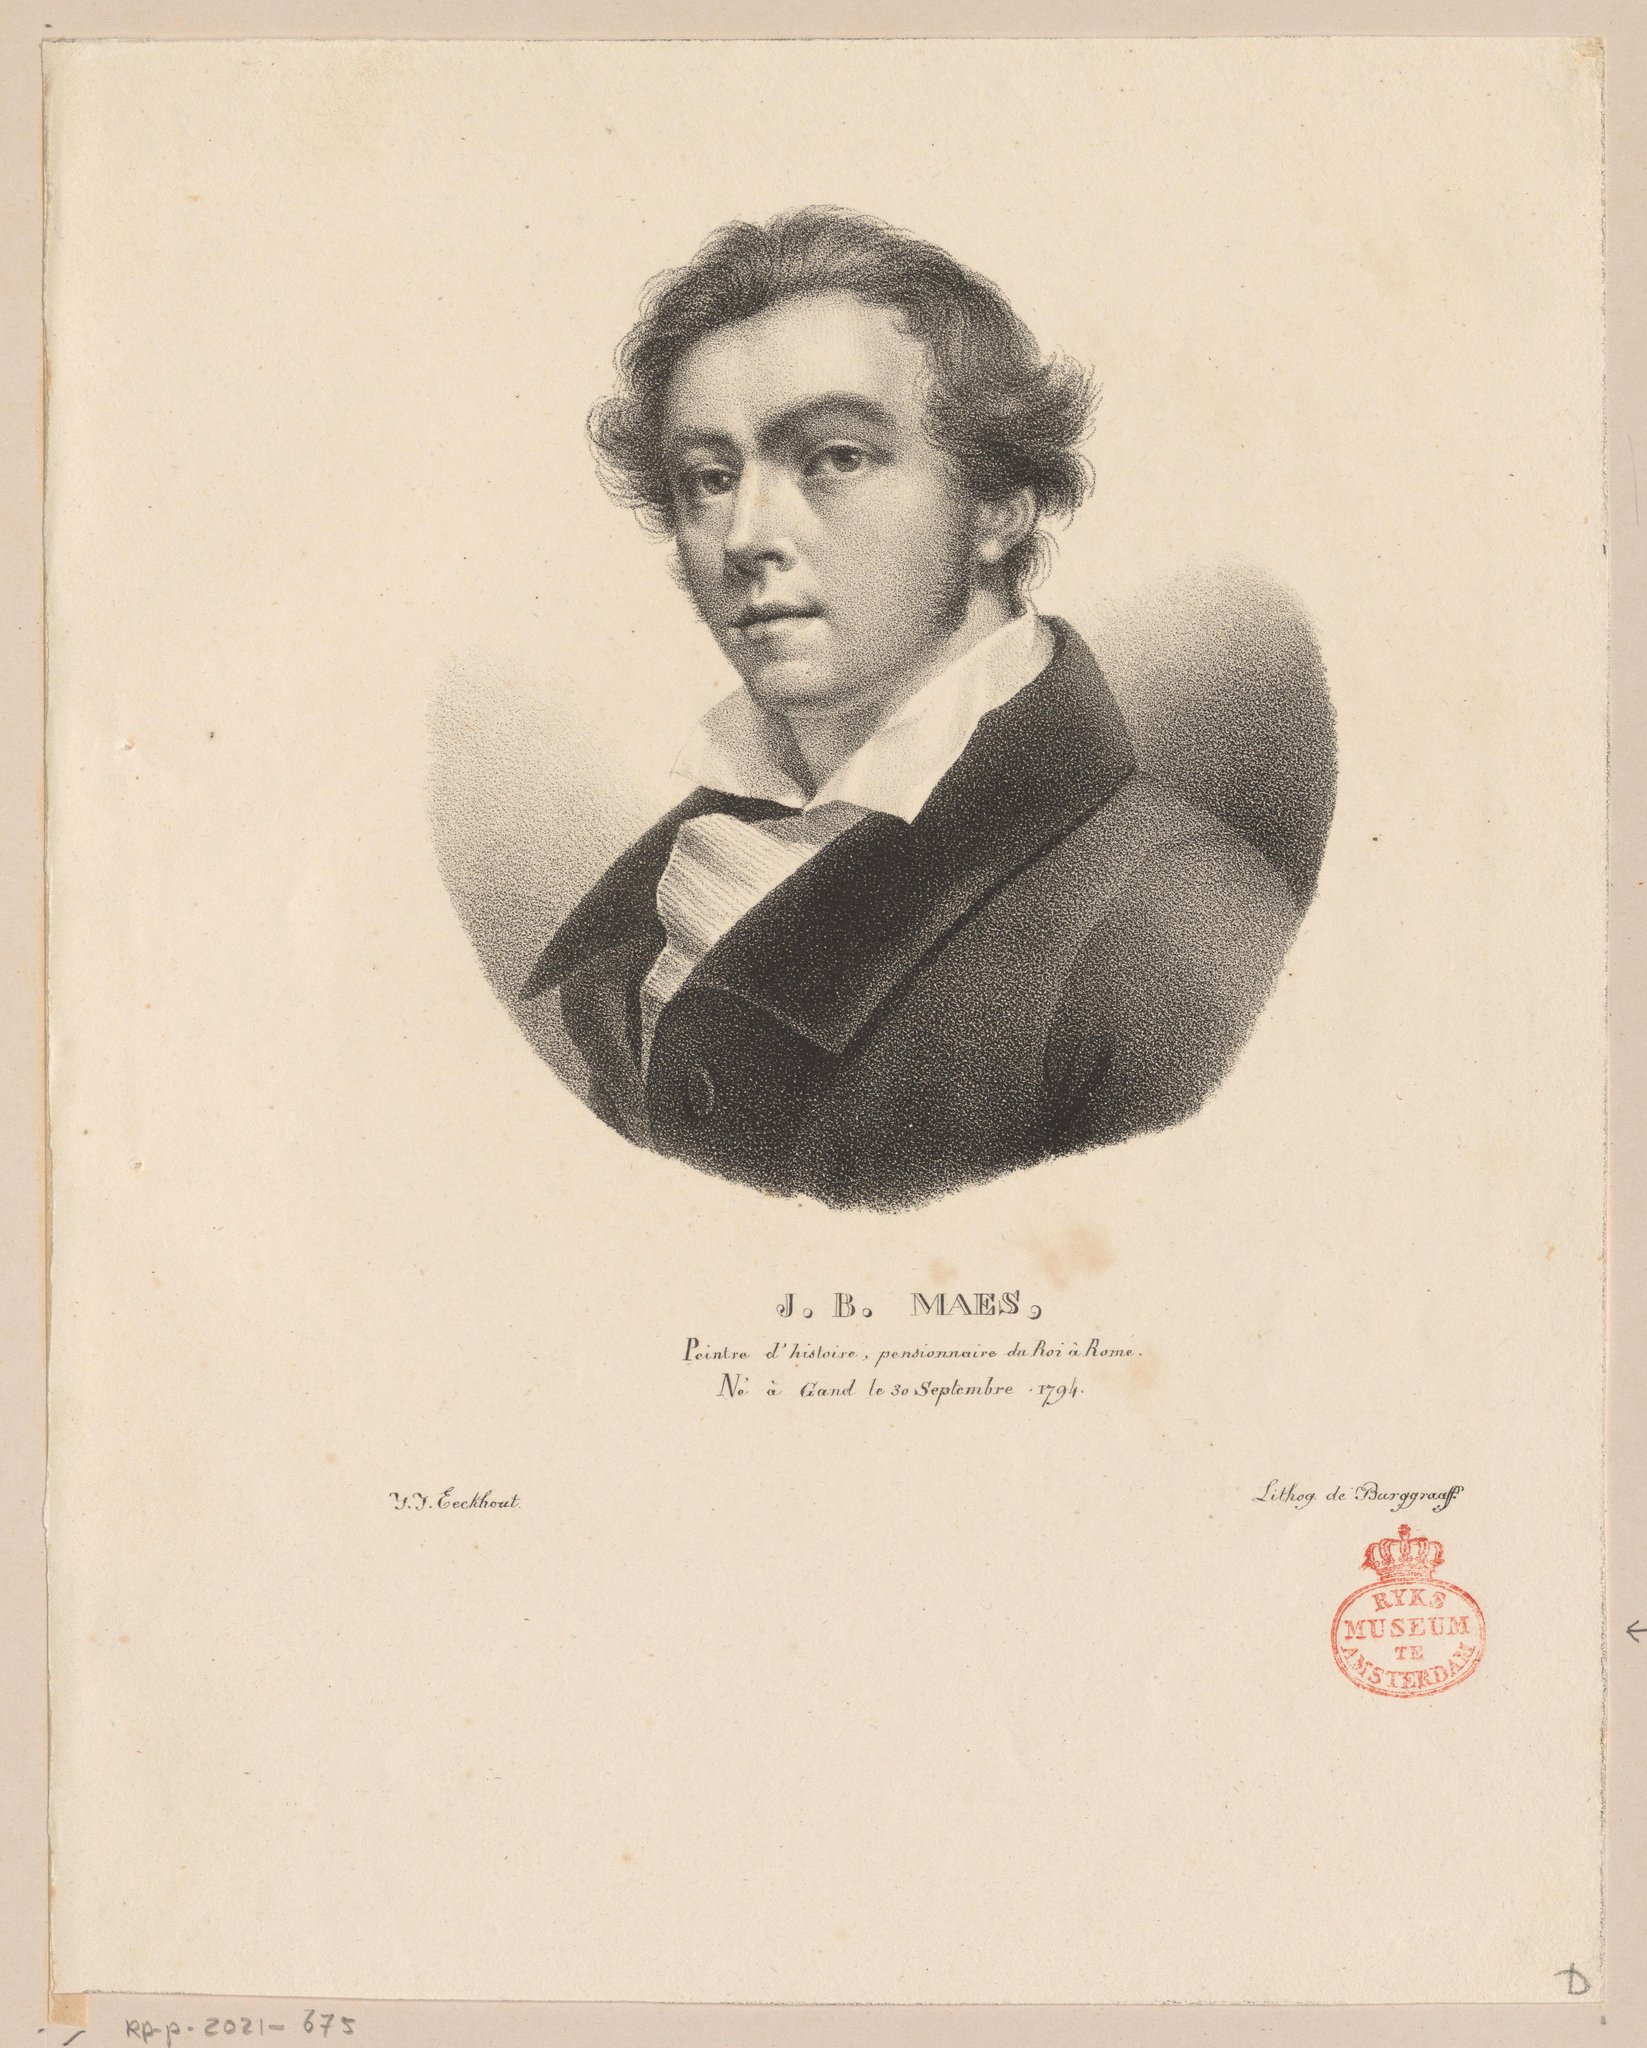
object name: print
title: Portretten van hedendaagse kunstenaars uit het Verenigd Koninkrijk der Nederlanden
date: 1822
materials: paper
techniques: lithograph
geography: brussels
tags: ghent, rome, painter, jean baptiste louis maes canini, historical persons, portrait, self-portrait of painter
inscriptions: collector's mark: Lugt 12